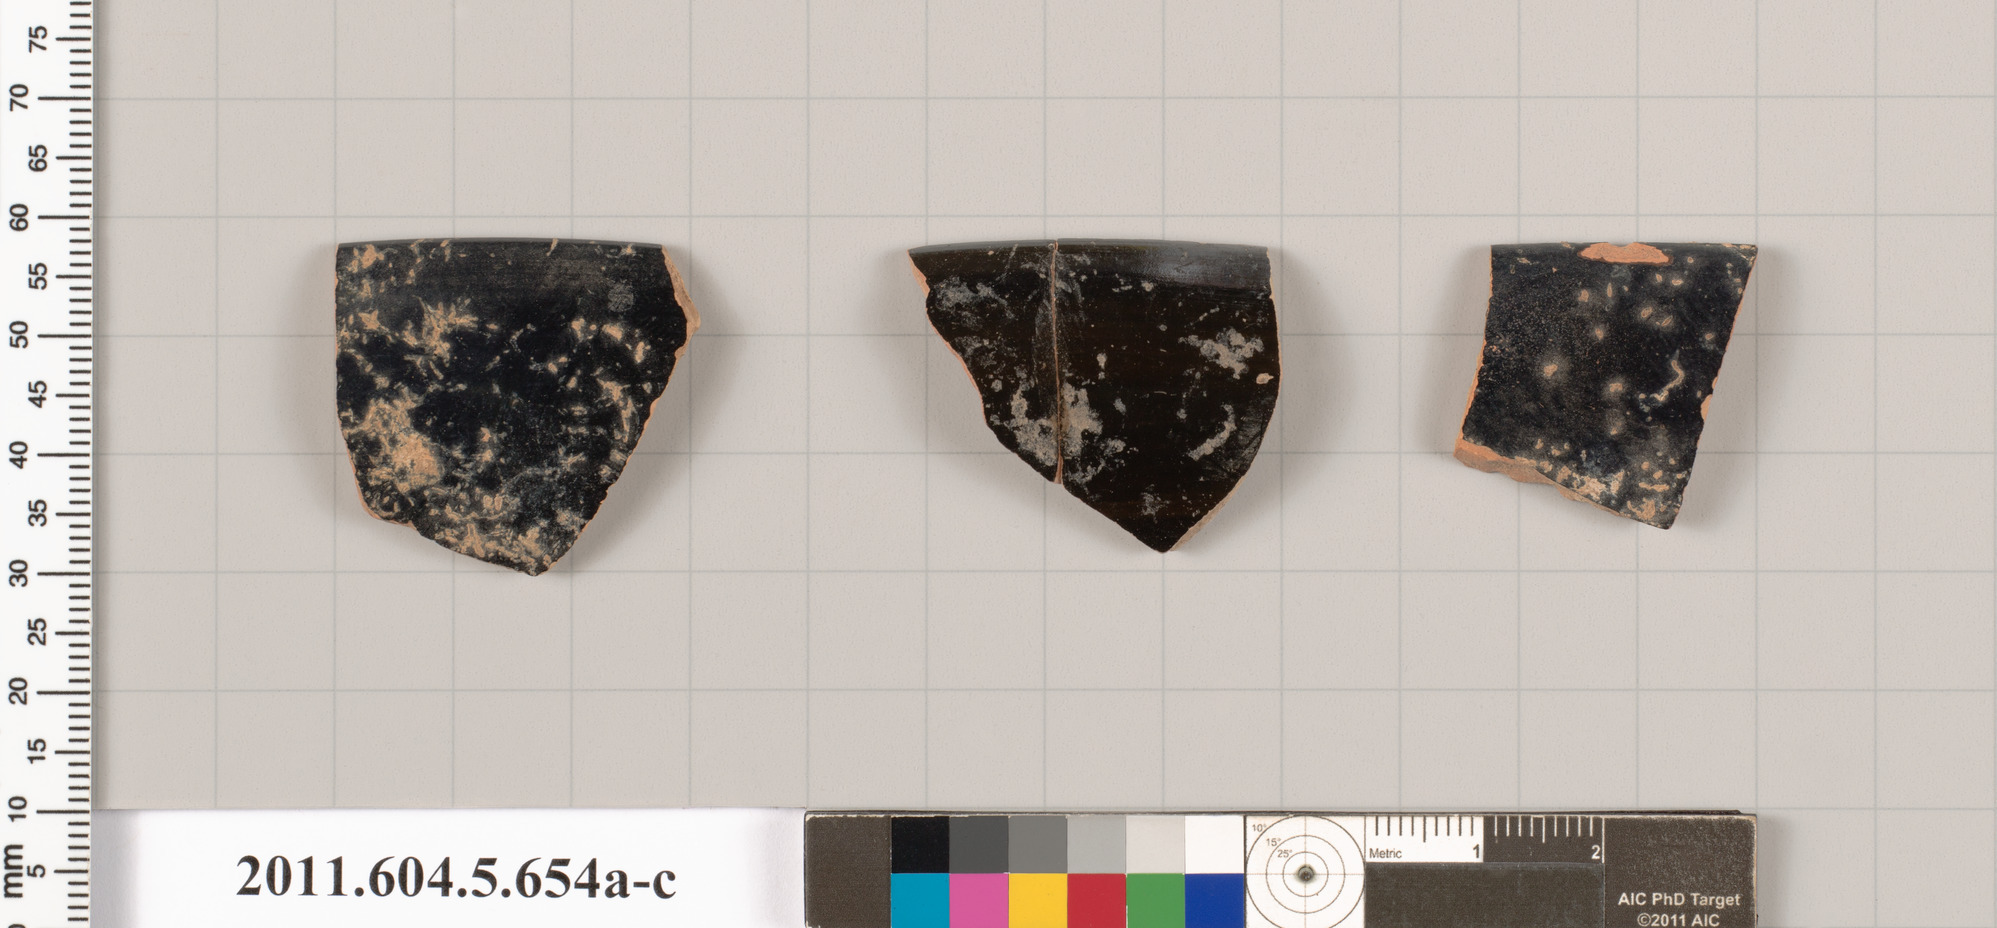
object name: kylix fragment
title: Terracotta rim fragments of kylikes (drinking cups)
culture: greek, attic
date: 600-401 BCE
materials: terracotta